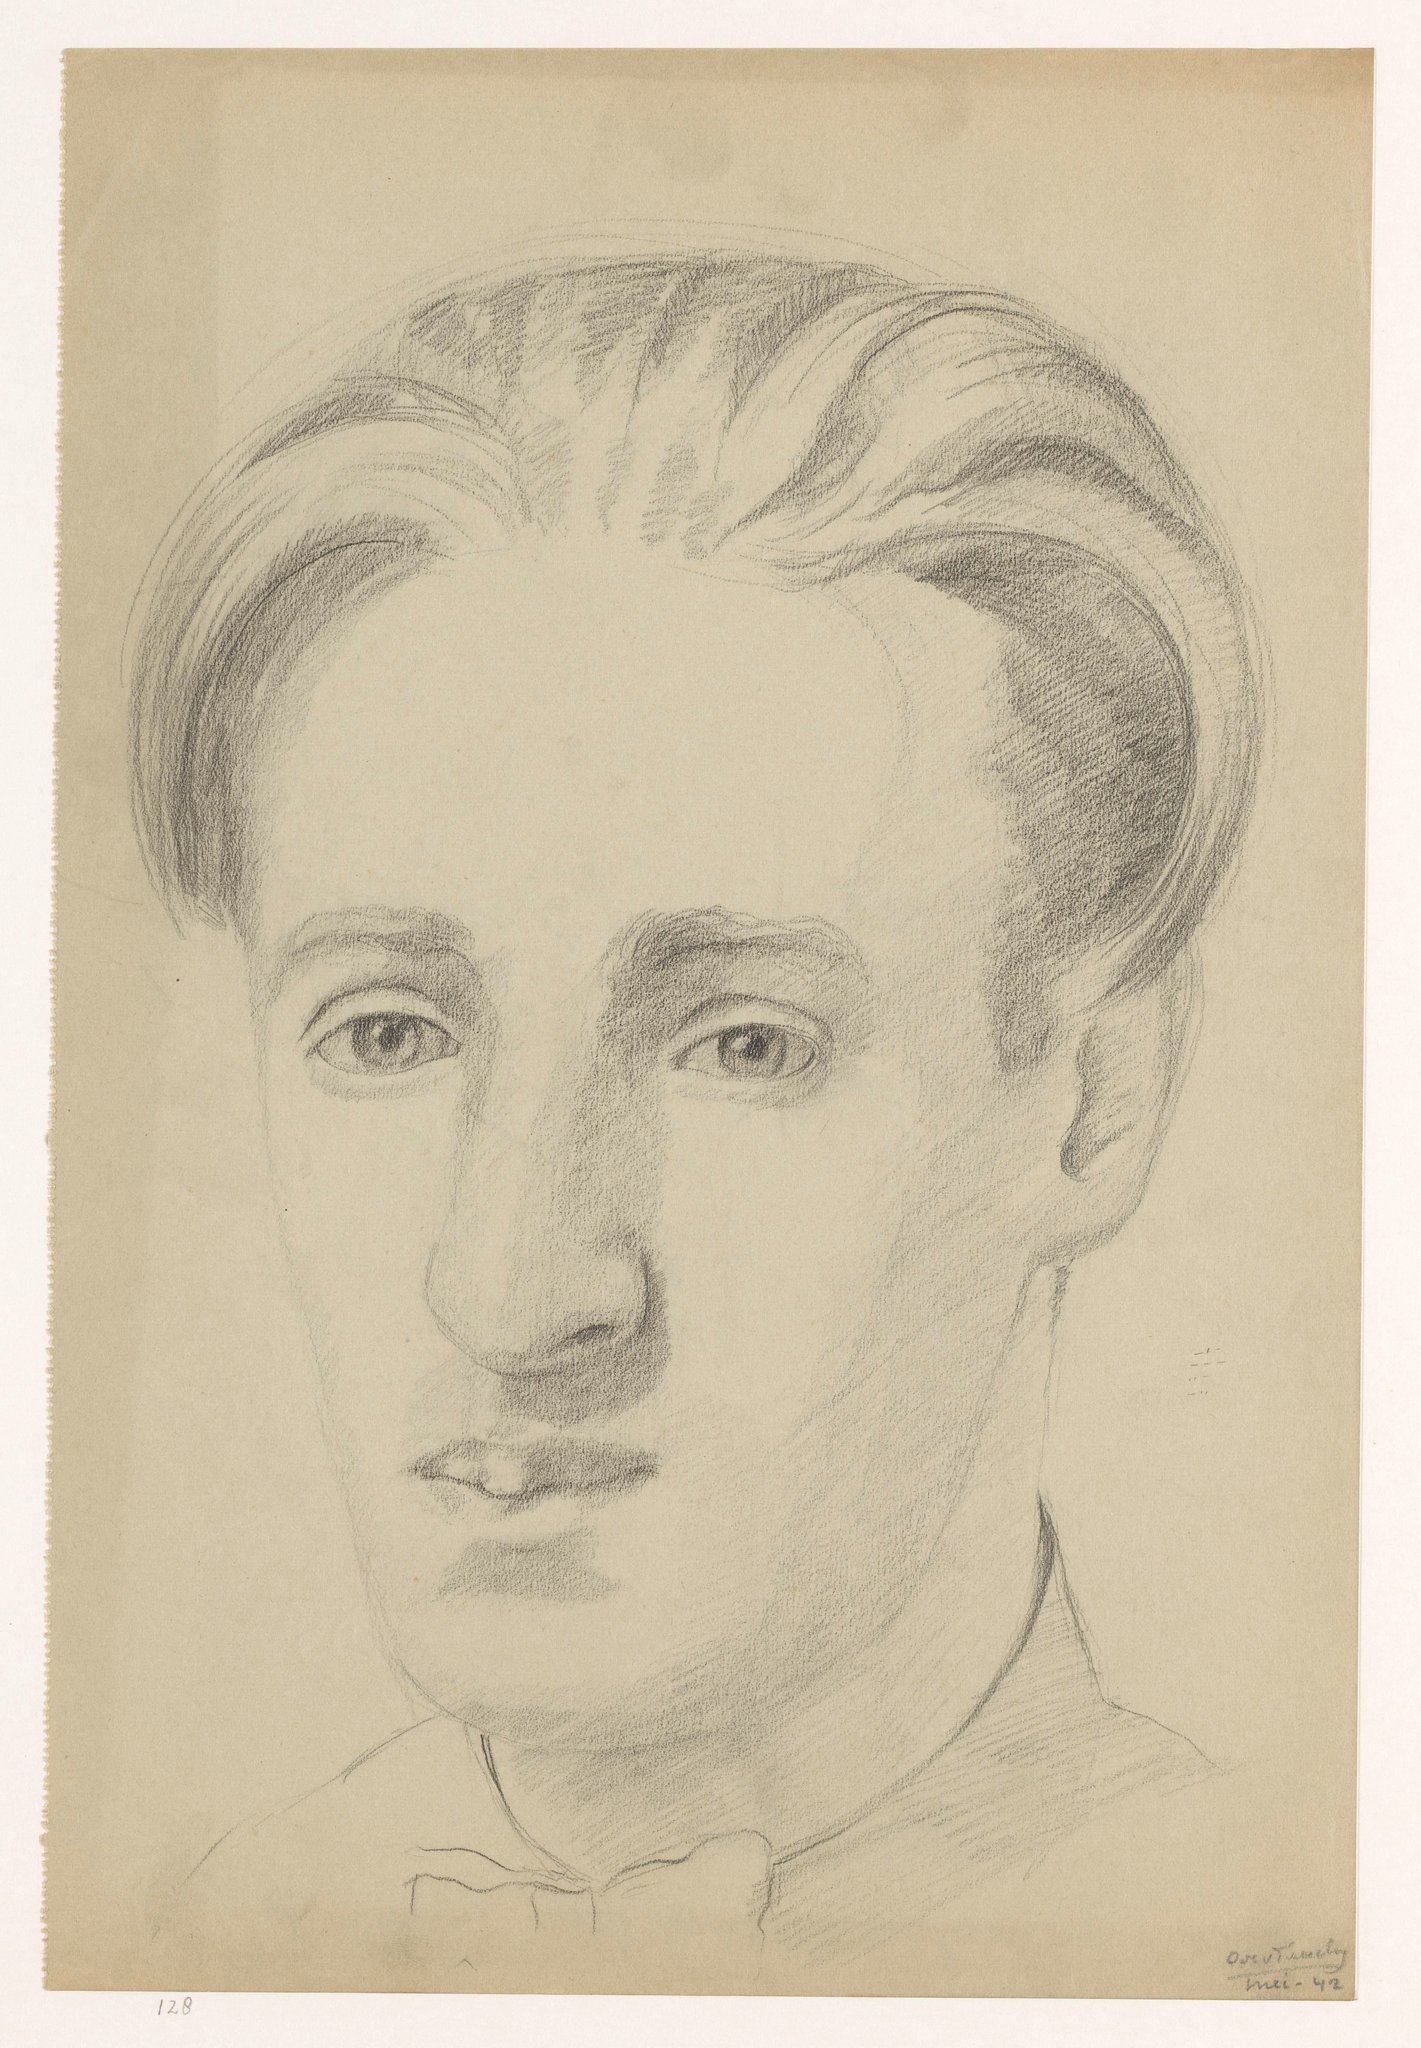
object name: drawing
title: Zelfportretten van Cor van Teeseling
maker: cor van teeseling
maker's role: draughtsman, sculptor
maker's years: 1915-1942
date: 1905-1942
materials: chalk, paper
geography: amsterdam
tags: amsterdam, draughtsman, sculptor, cor van teeseling, historical persons, prisoner in cell or locked place, portrait, self-portrait of draughtsman, netherlands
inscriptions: inscription: ‘veel kussen’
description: Zelfportret van Cor van Teeseling, mei 1942. Cor van Teeseling driekwart afgebeeld, zijn hoofd naar links gewend.